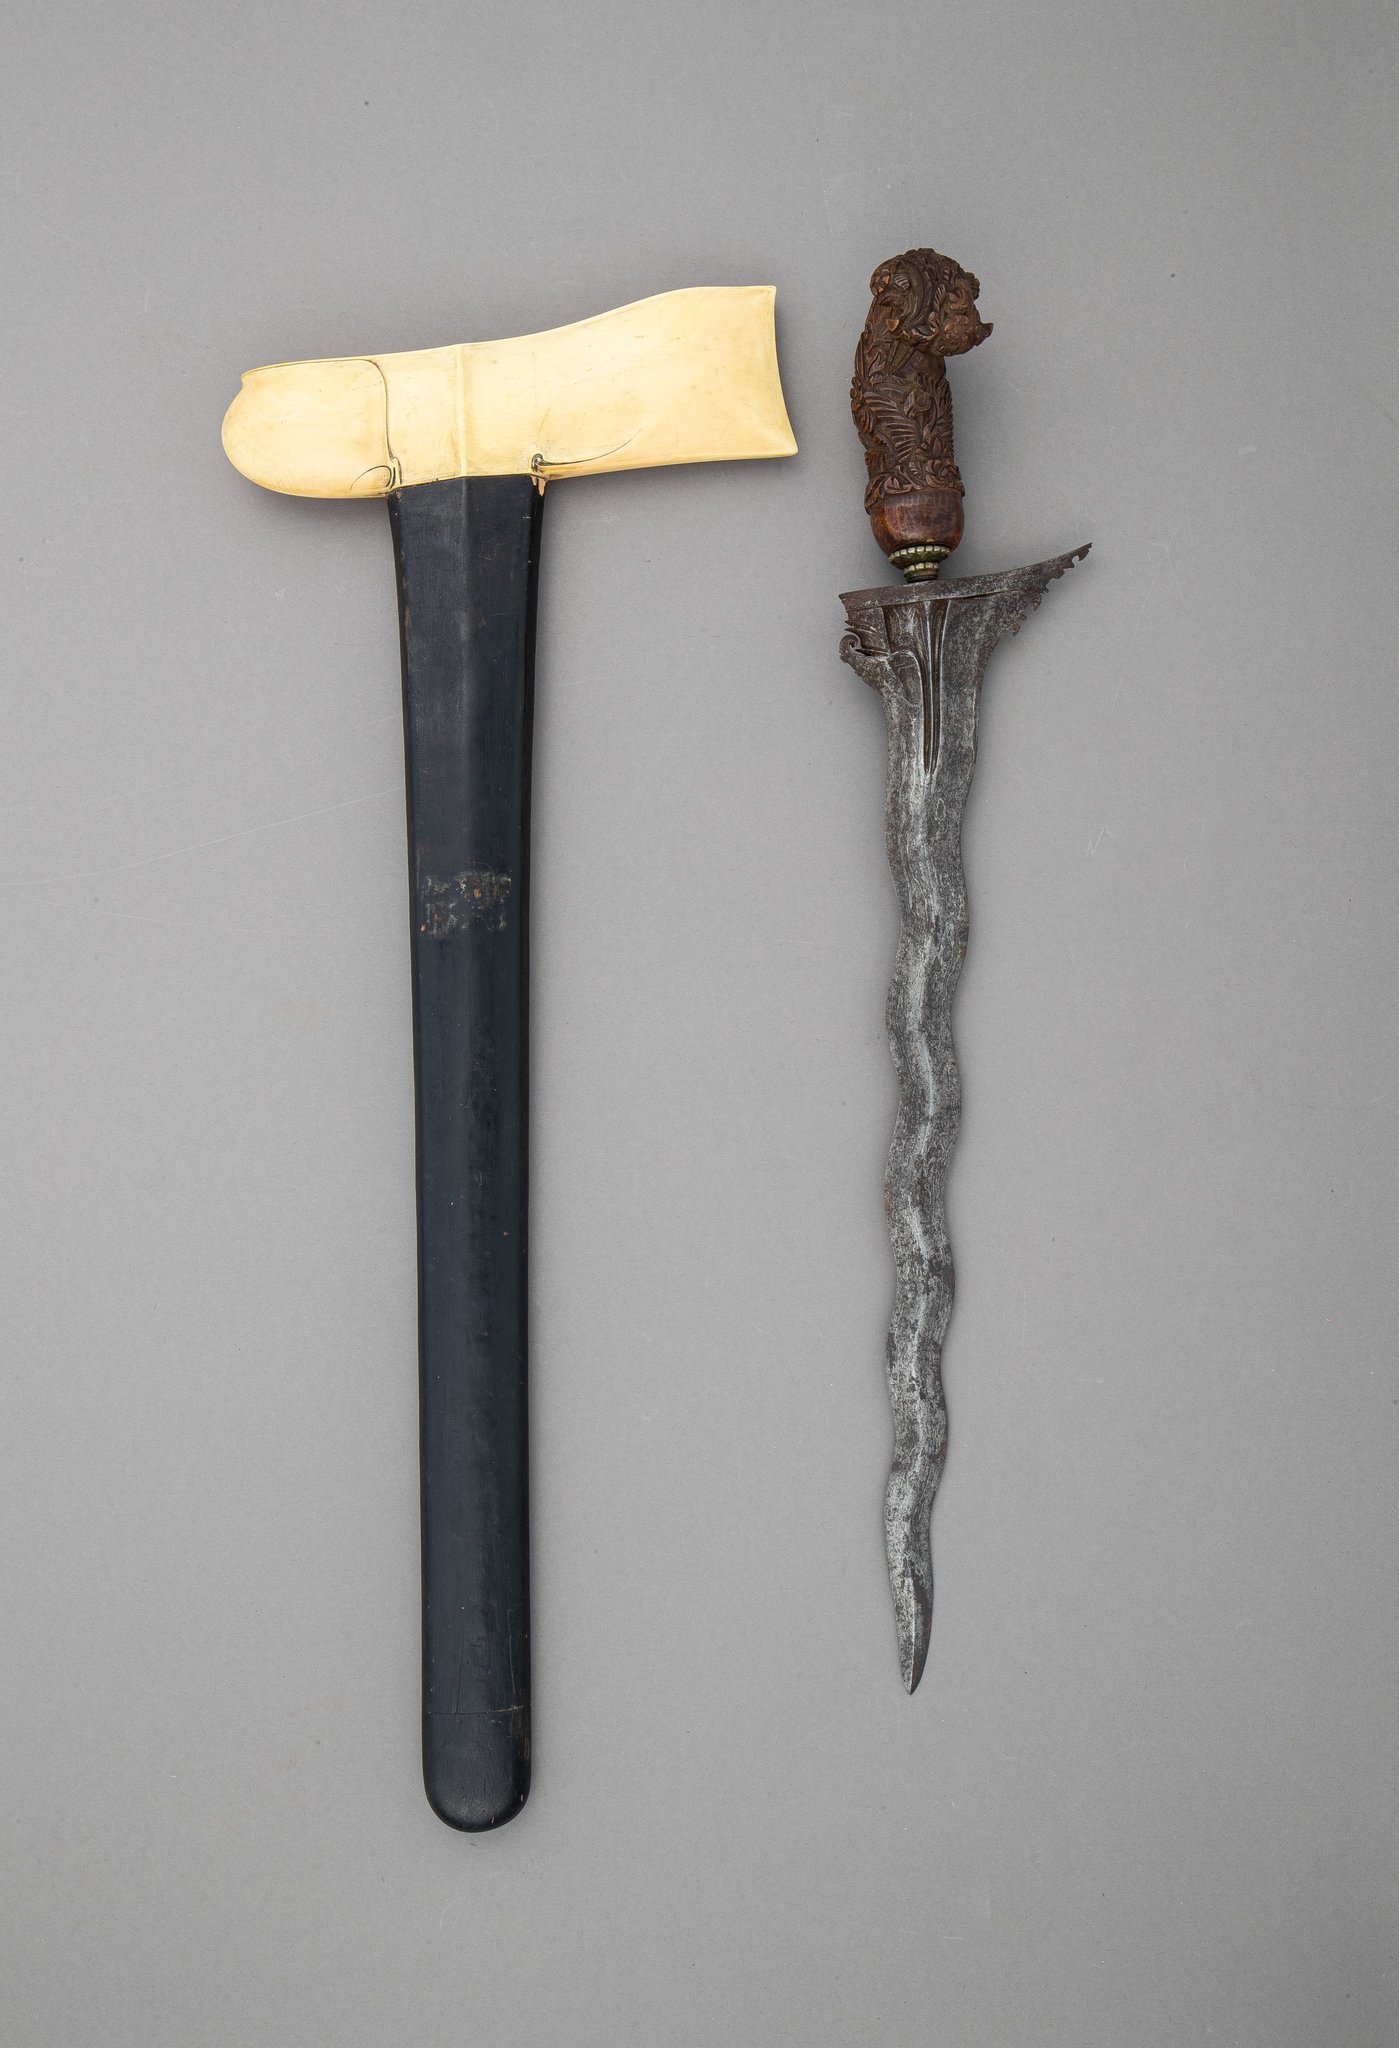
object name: kris with sheath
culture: balinese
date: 1501-1900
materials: ivory, silver, steel, wood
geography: indonesia